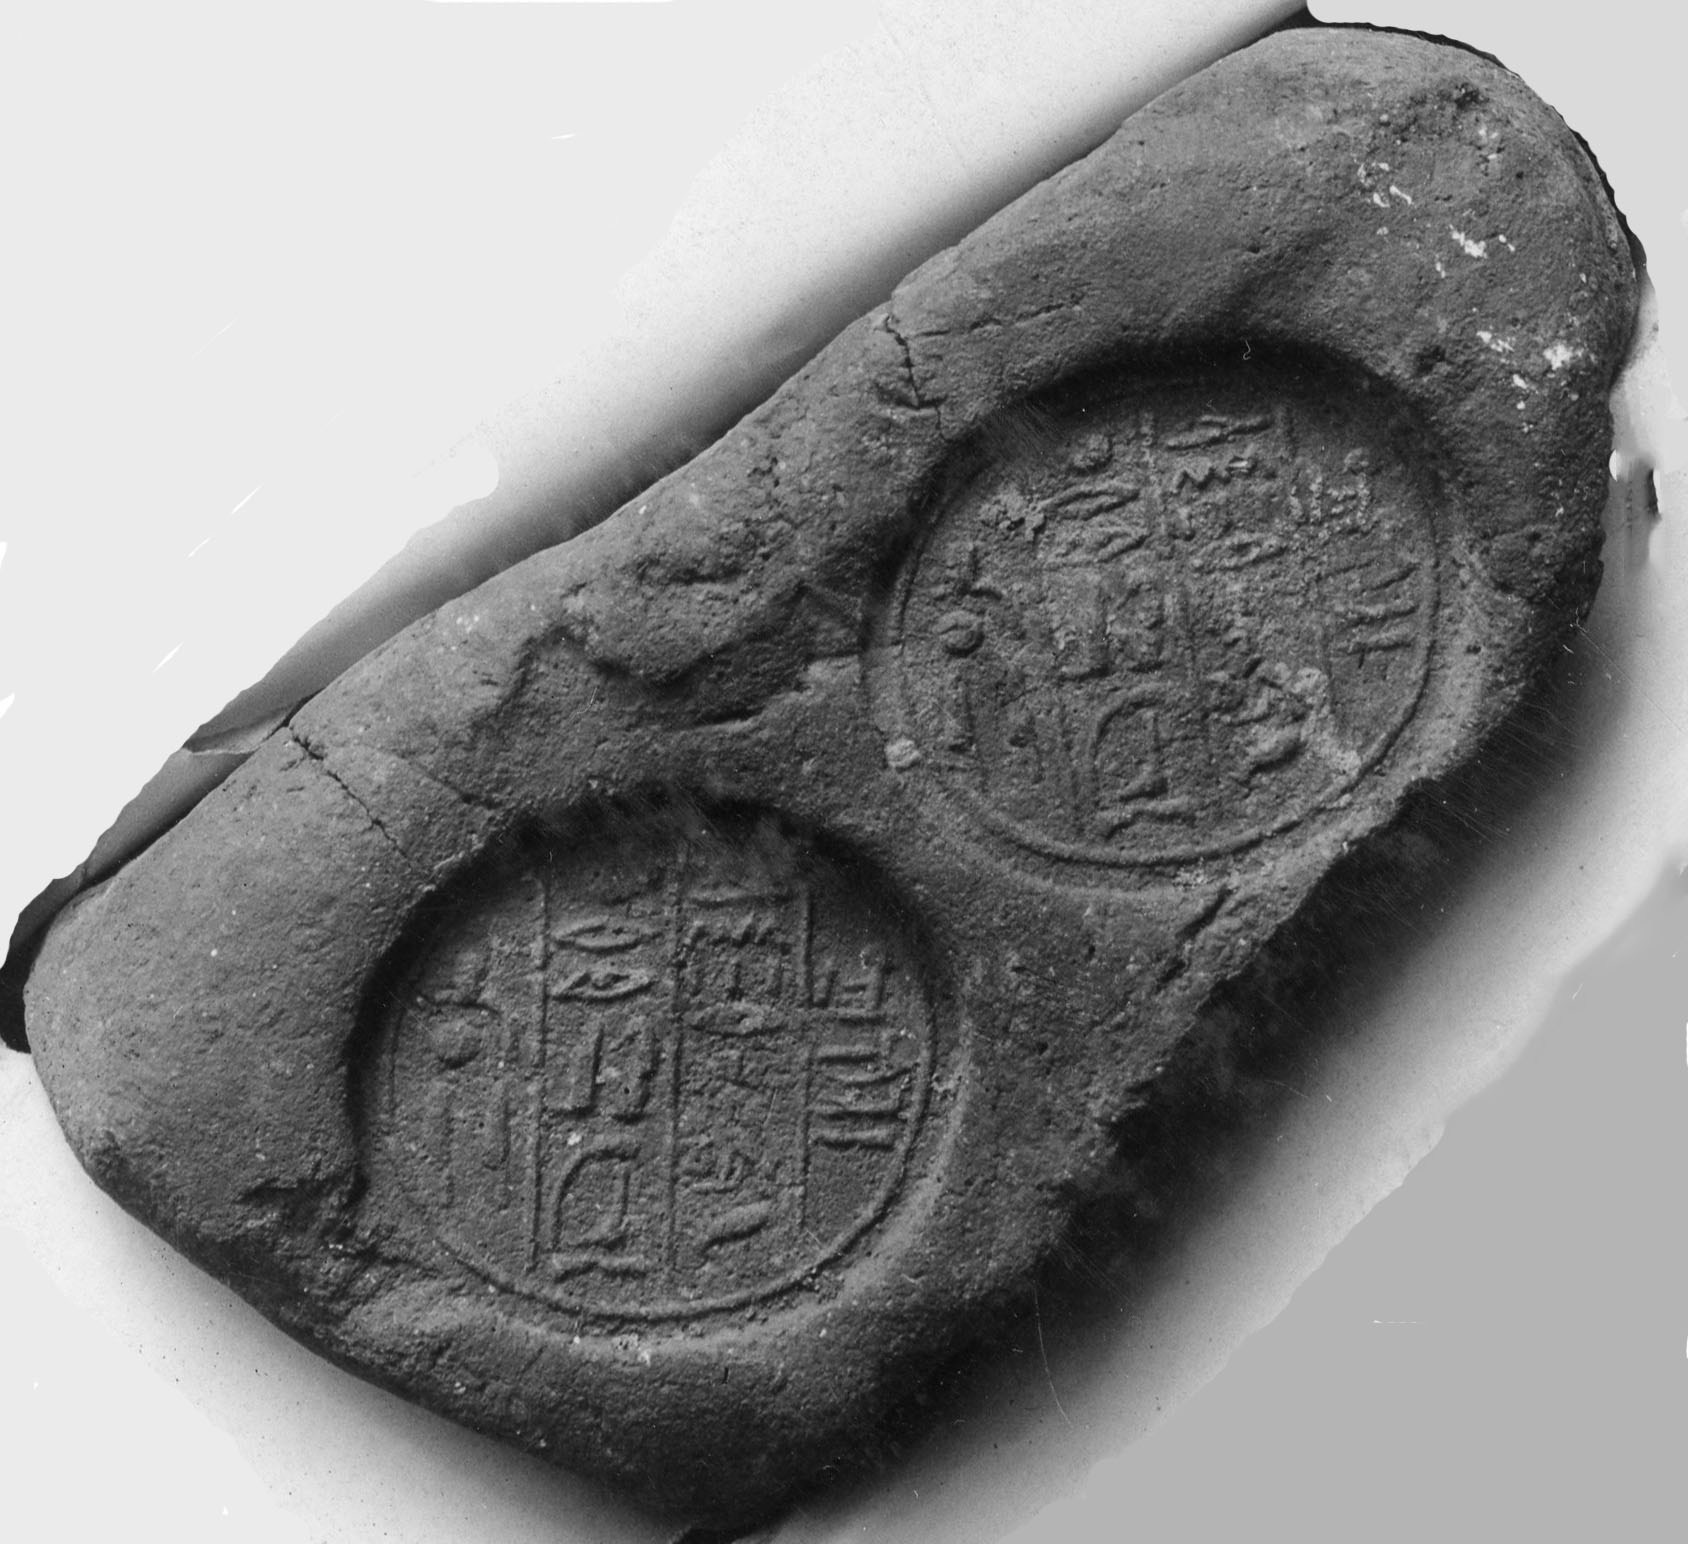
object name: brick, stamp, wab priest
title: Funerary Cone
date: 1550-1295 BCE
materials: pottery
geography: egypt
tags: hieroglyphs